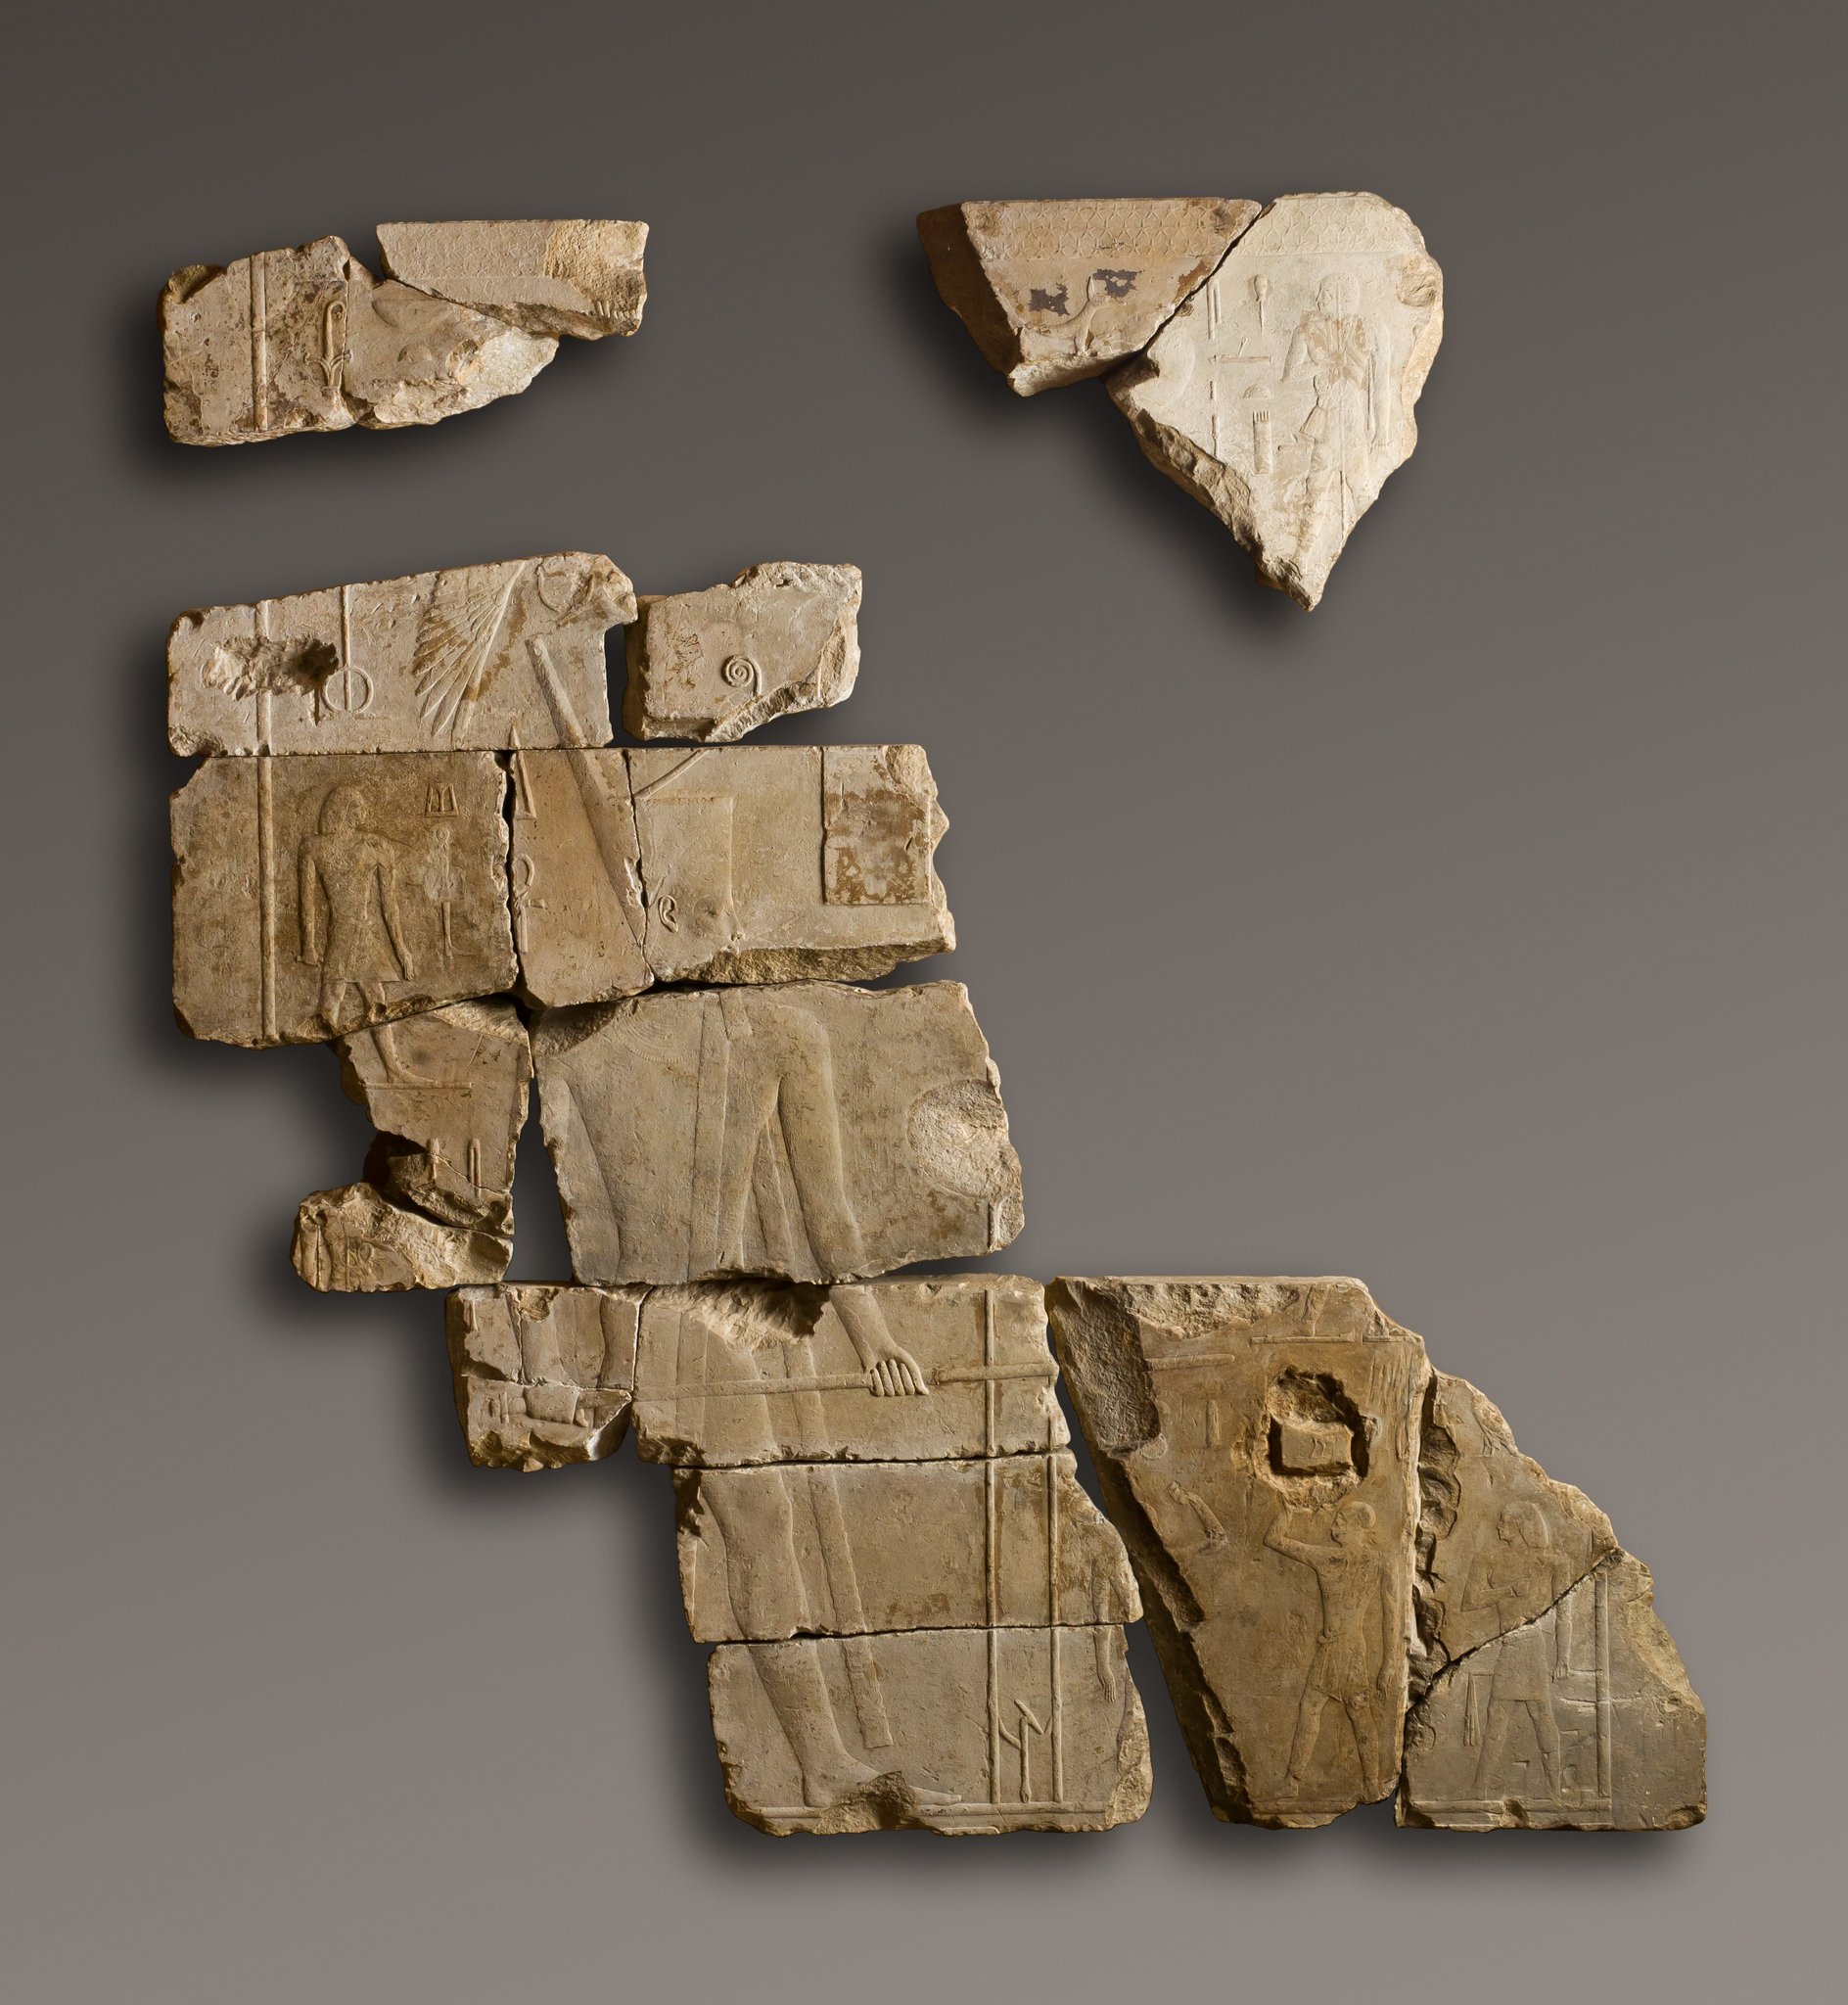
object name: relief, wall, apries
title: Relief from the Palace of Apries in Memphis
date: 589-570 BCE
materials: limestone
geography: egypt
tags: men